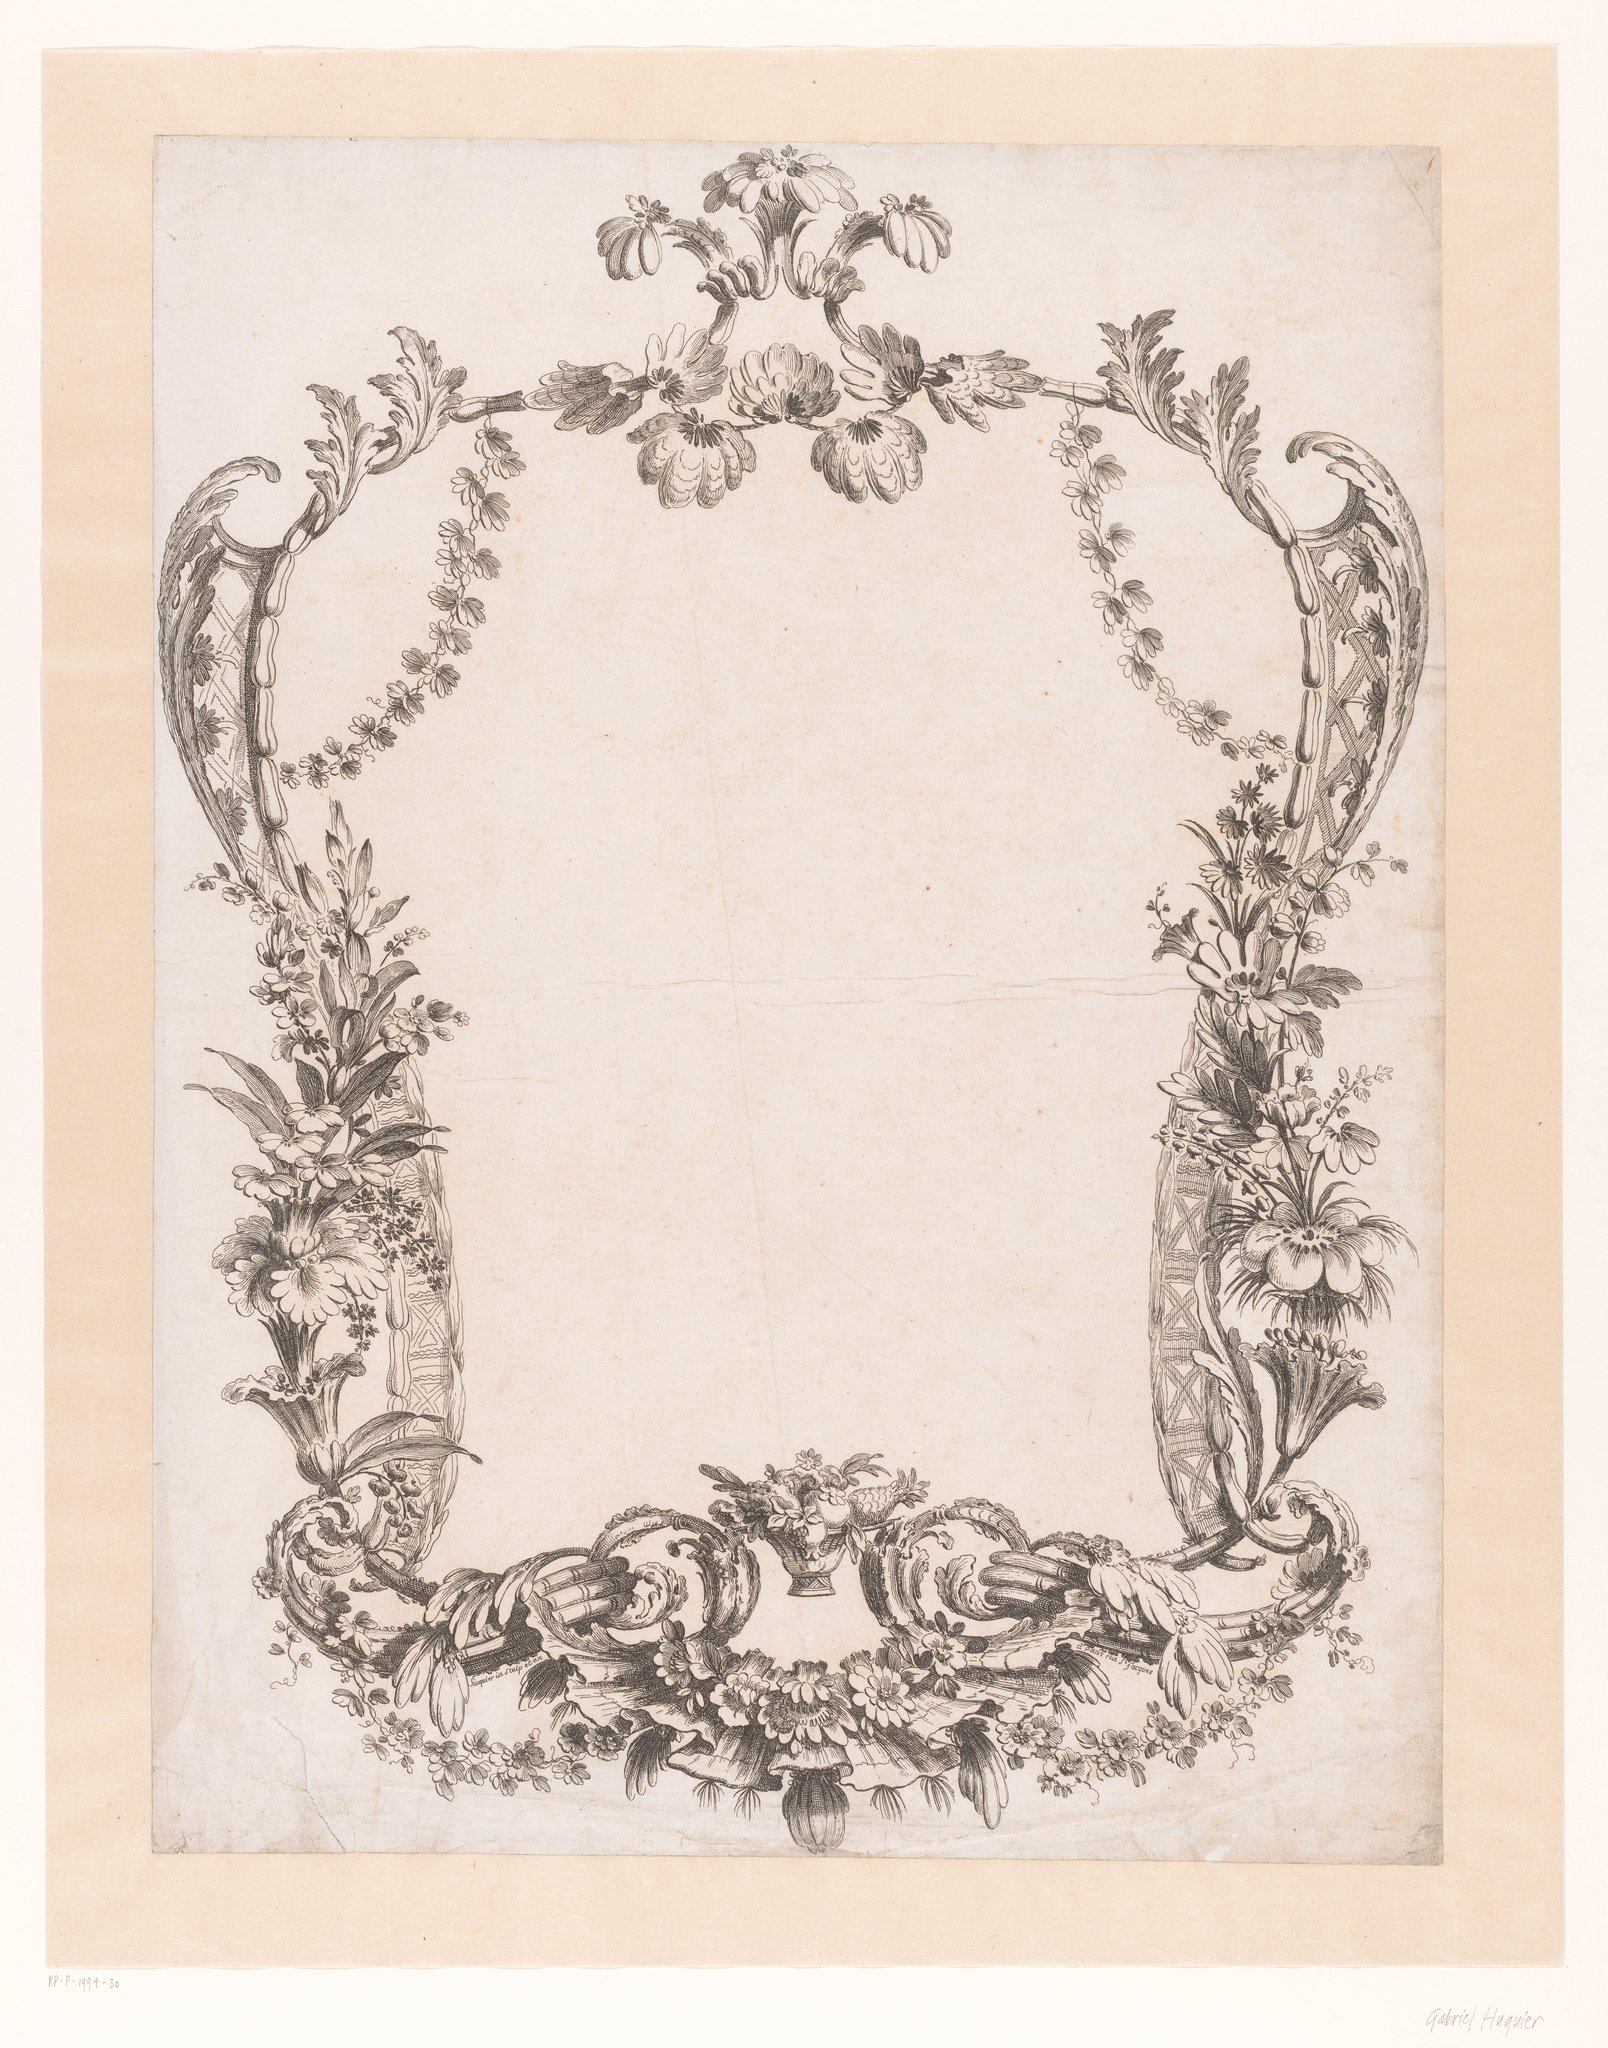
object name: print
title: Ontwerp voor een cartouche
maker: gabriel huquier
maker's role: painter, print maker, publisher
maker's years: 1695-1772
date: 1705-1772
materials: paper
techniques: etching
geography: paris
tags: ornament ~ cartouche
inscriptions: collector's mark: Lugt 2228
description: Ontwerp voor een cartouche bestaande uit bloemen, ranken en bladeren.